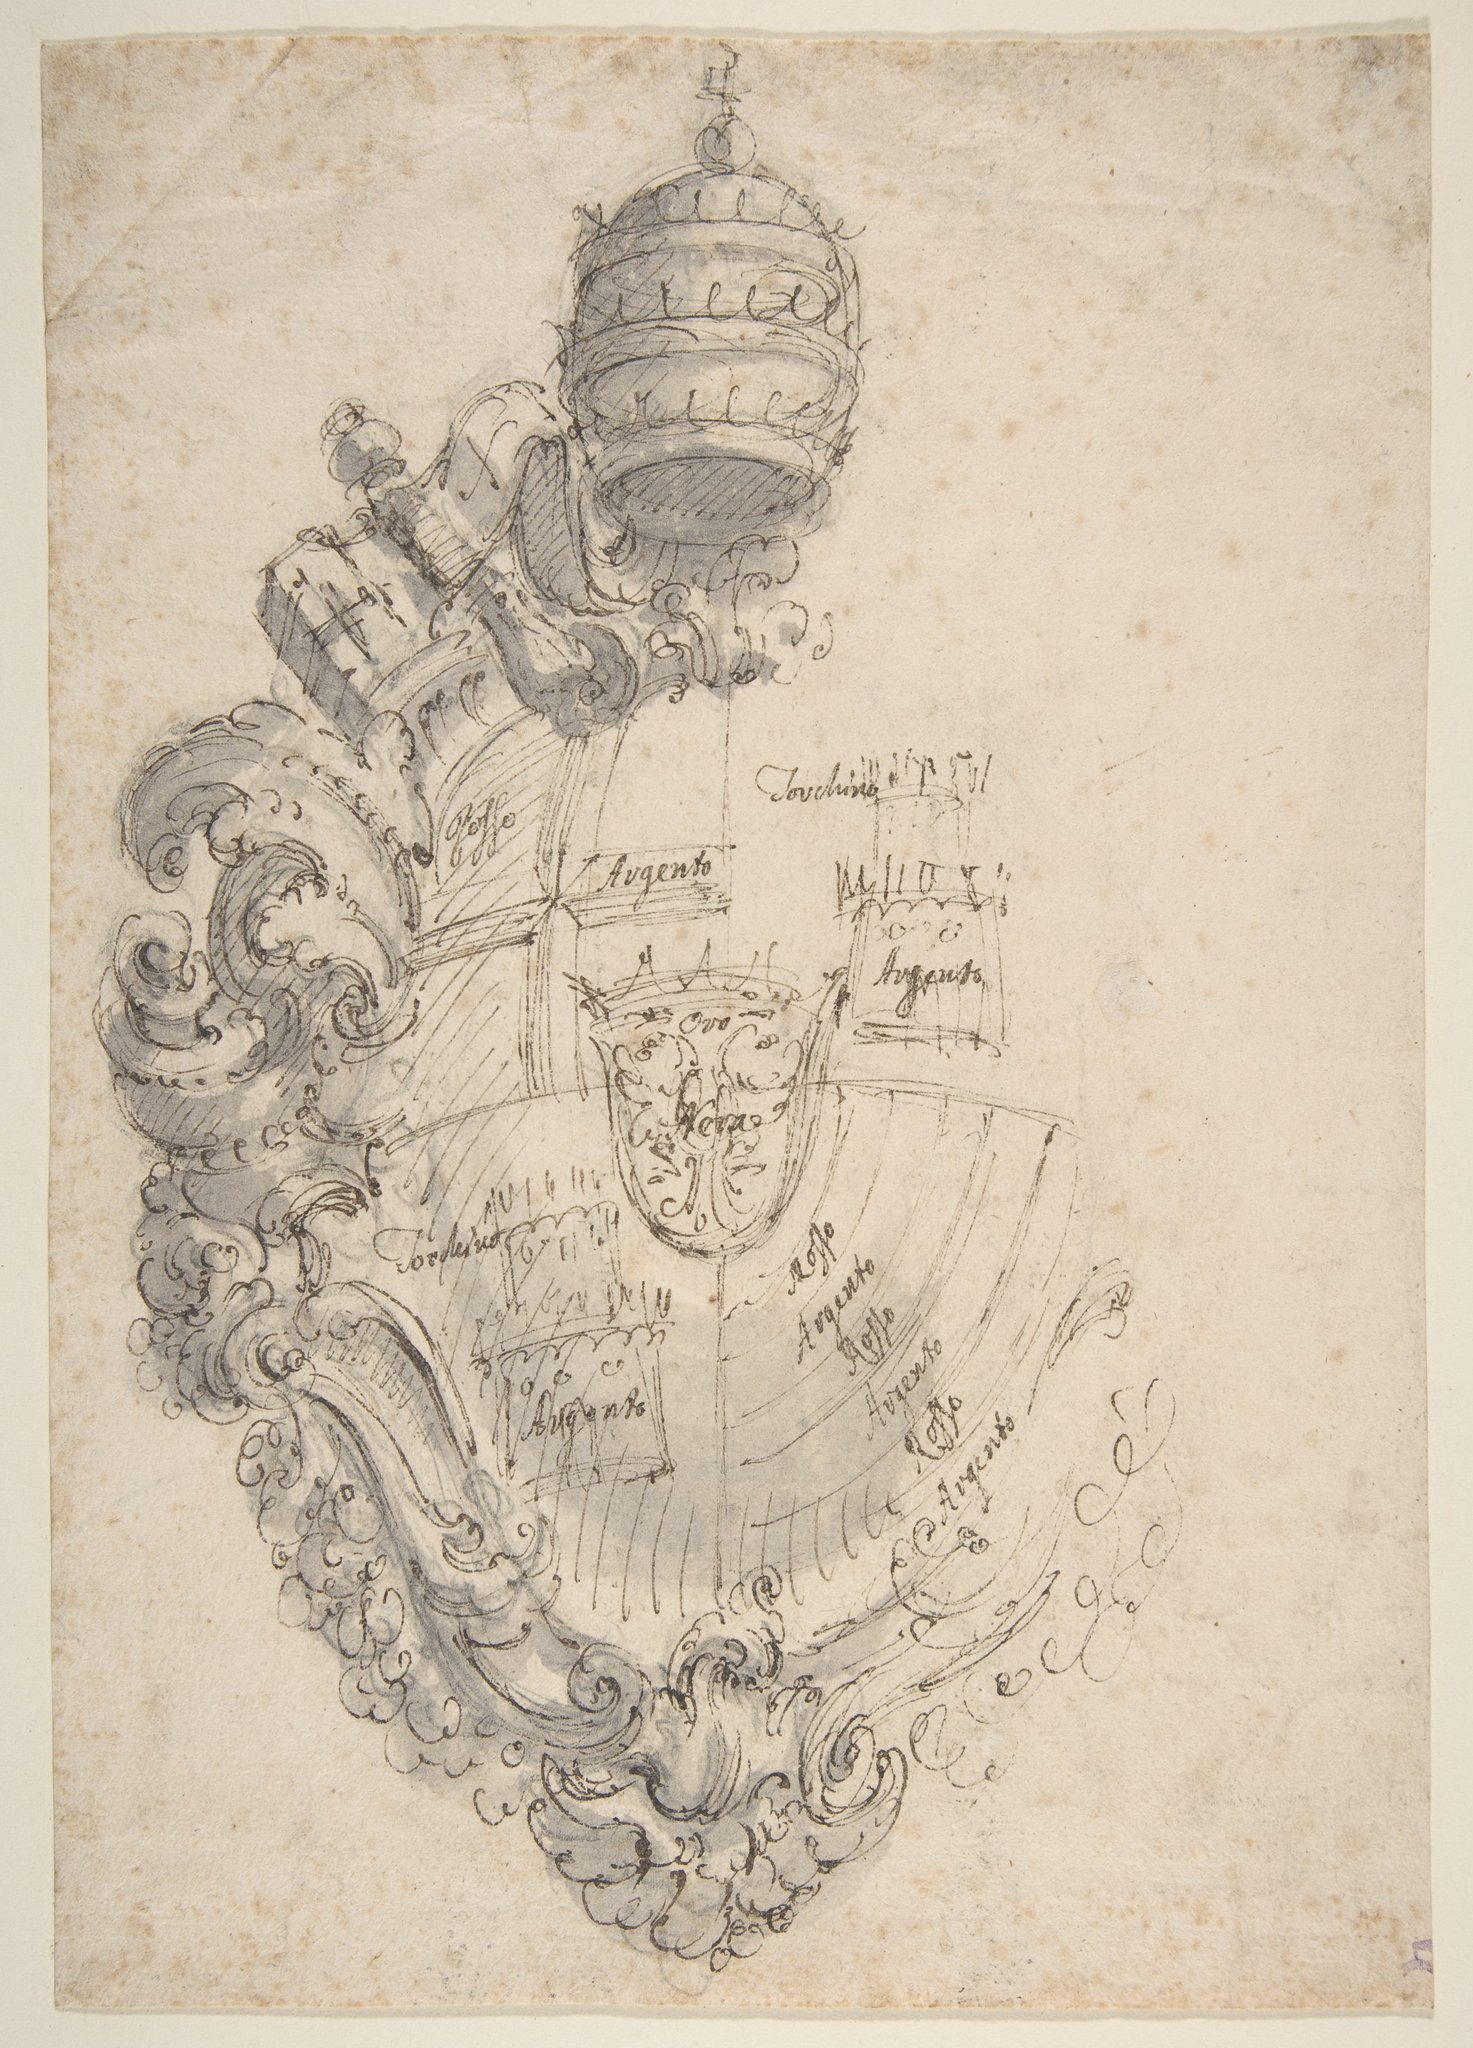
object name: drawing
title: Coat of Arms of Clement XIII (Rezzonico)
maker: giovanni battista piranesi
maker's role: artist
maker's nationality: italian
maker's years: 1720-1778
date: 1758-1769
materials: ink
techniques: pen, wash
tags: coat of arms